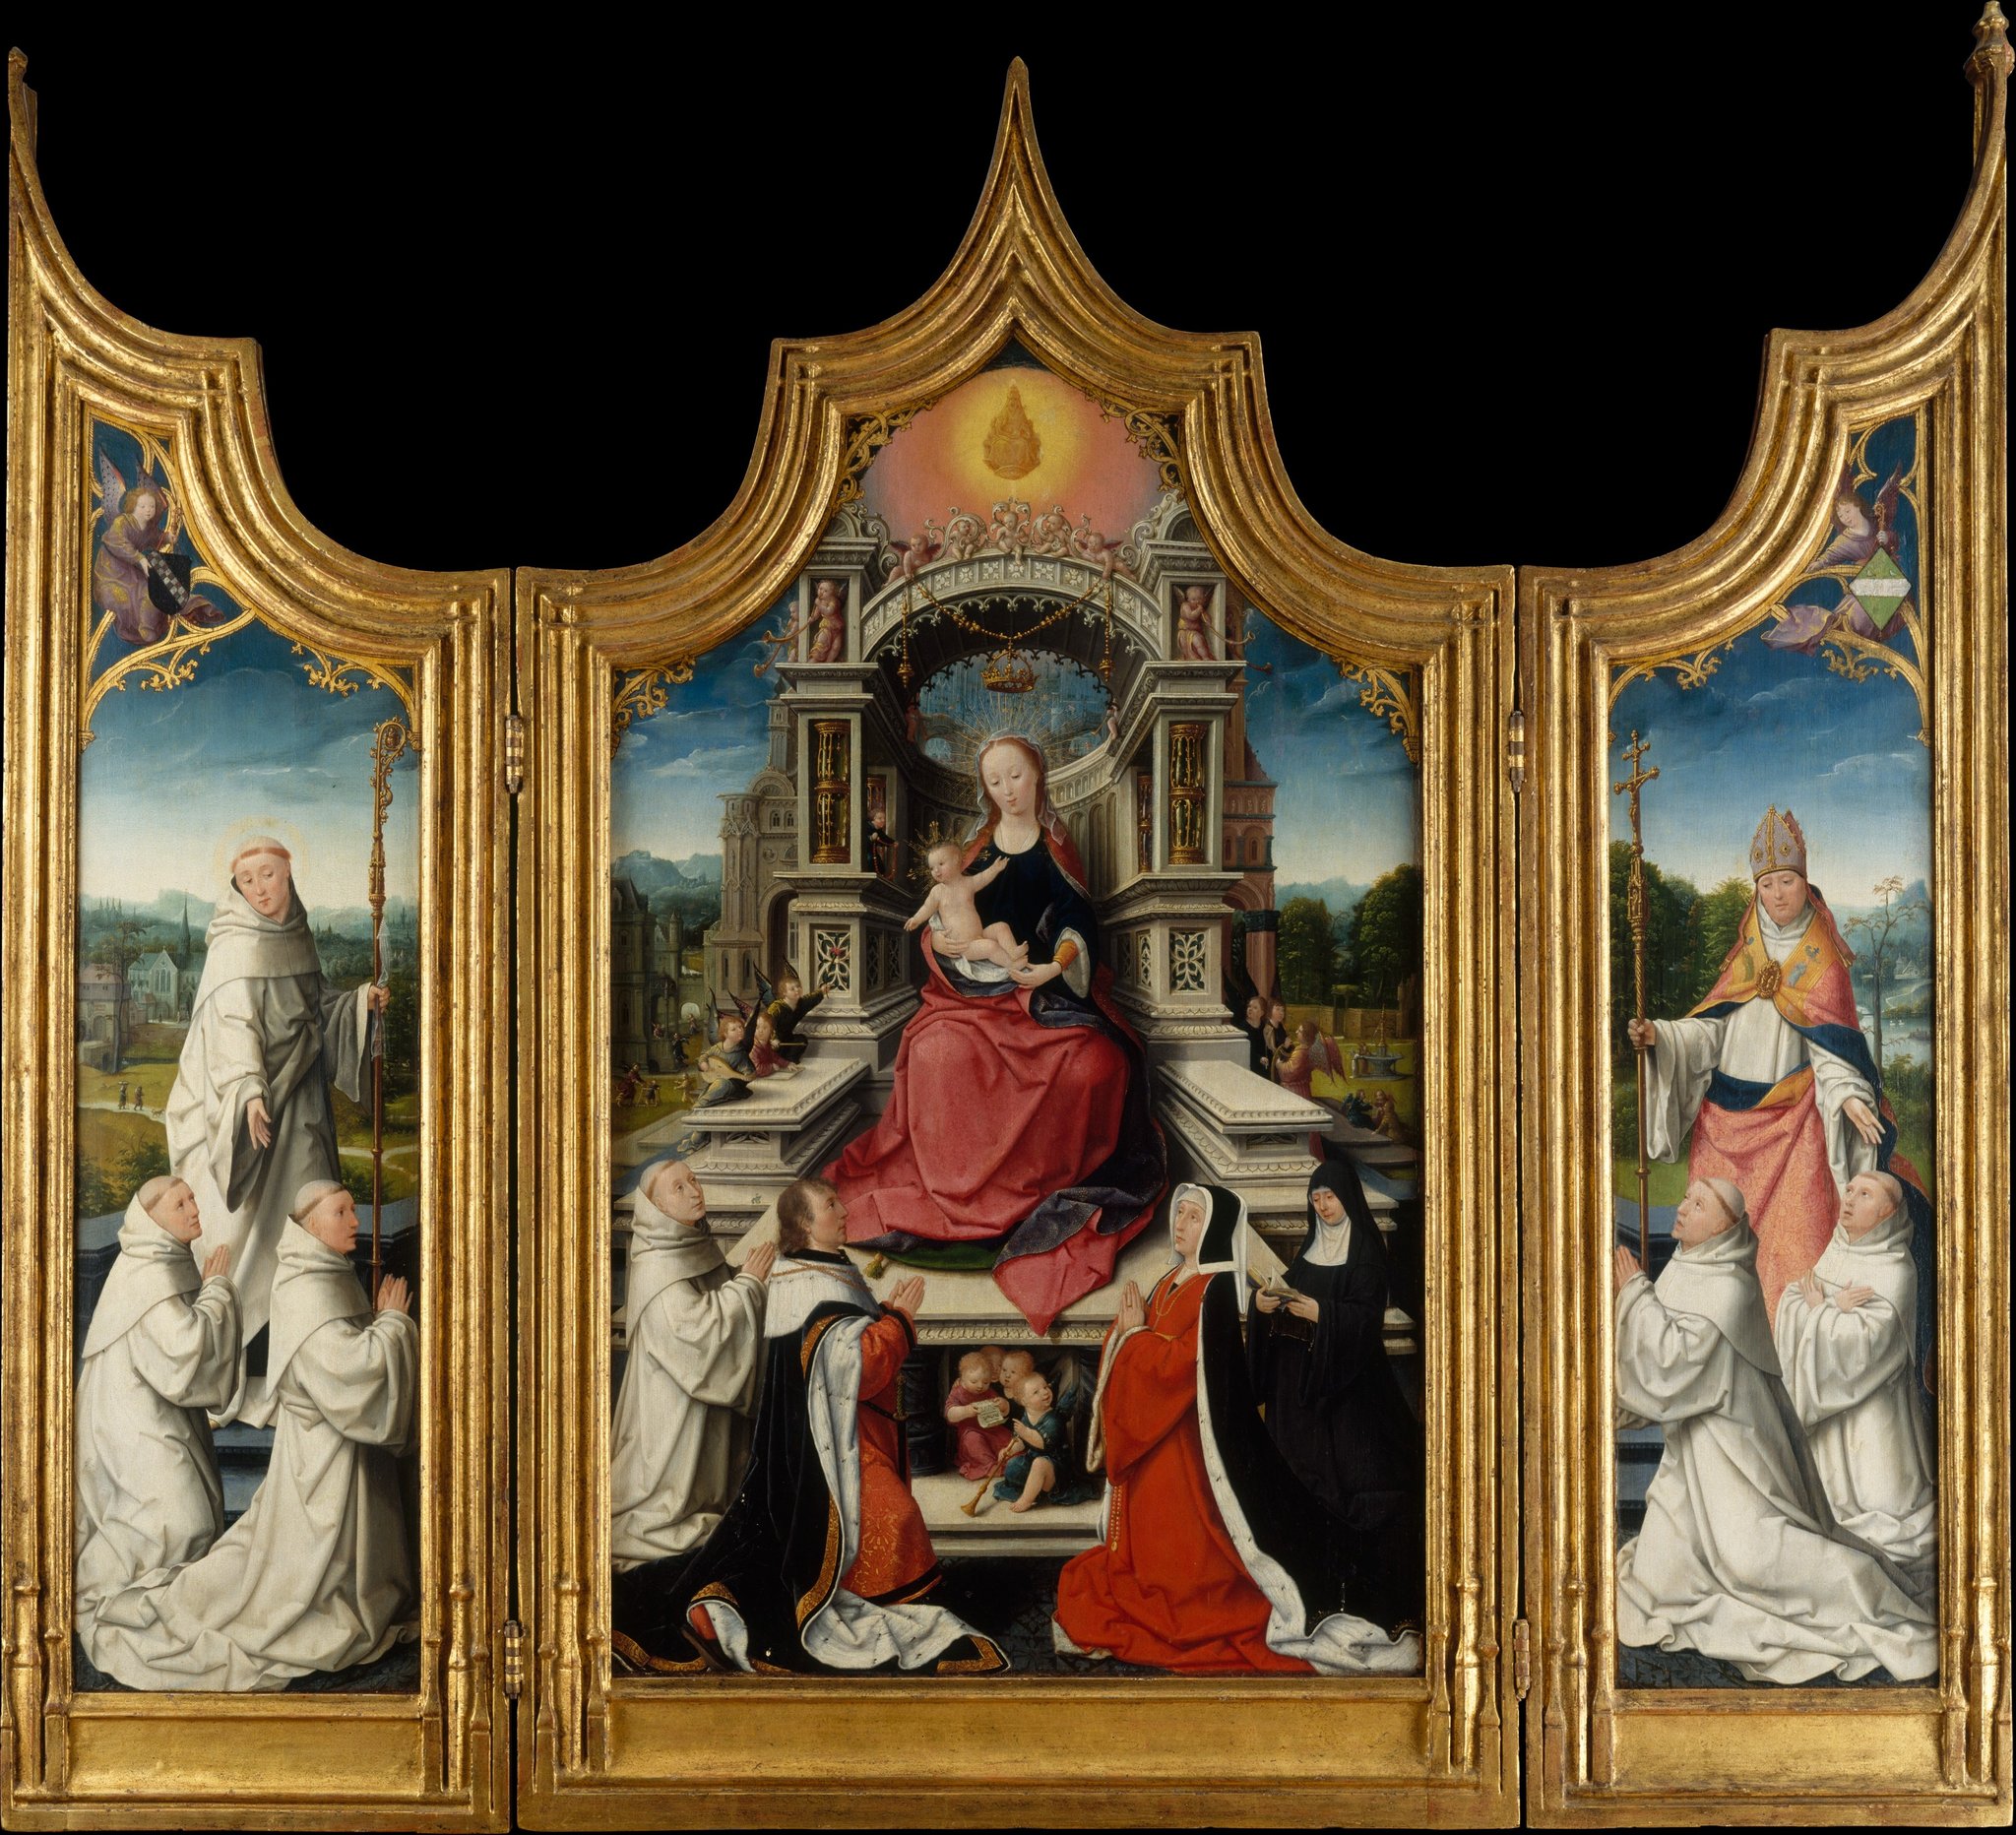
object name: painting, triptych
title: The Cellier Altarpiece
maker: jean bellegambe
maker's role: artist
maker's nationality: french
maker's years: 1470-1536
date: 1511-1512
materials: oil, wood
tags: men,women,angels,bishops,madonna and child,monks,saints